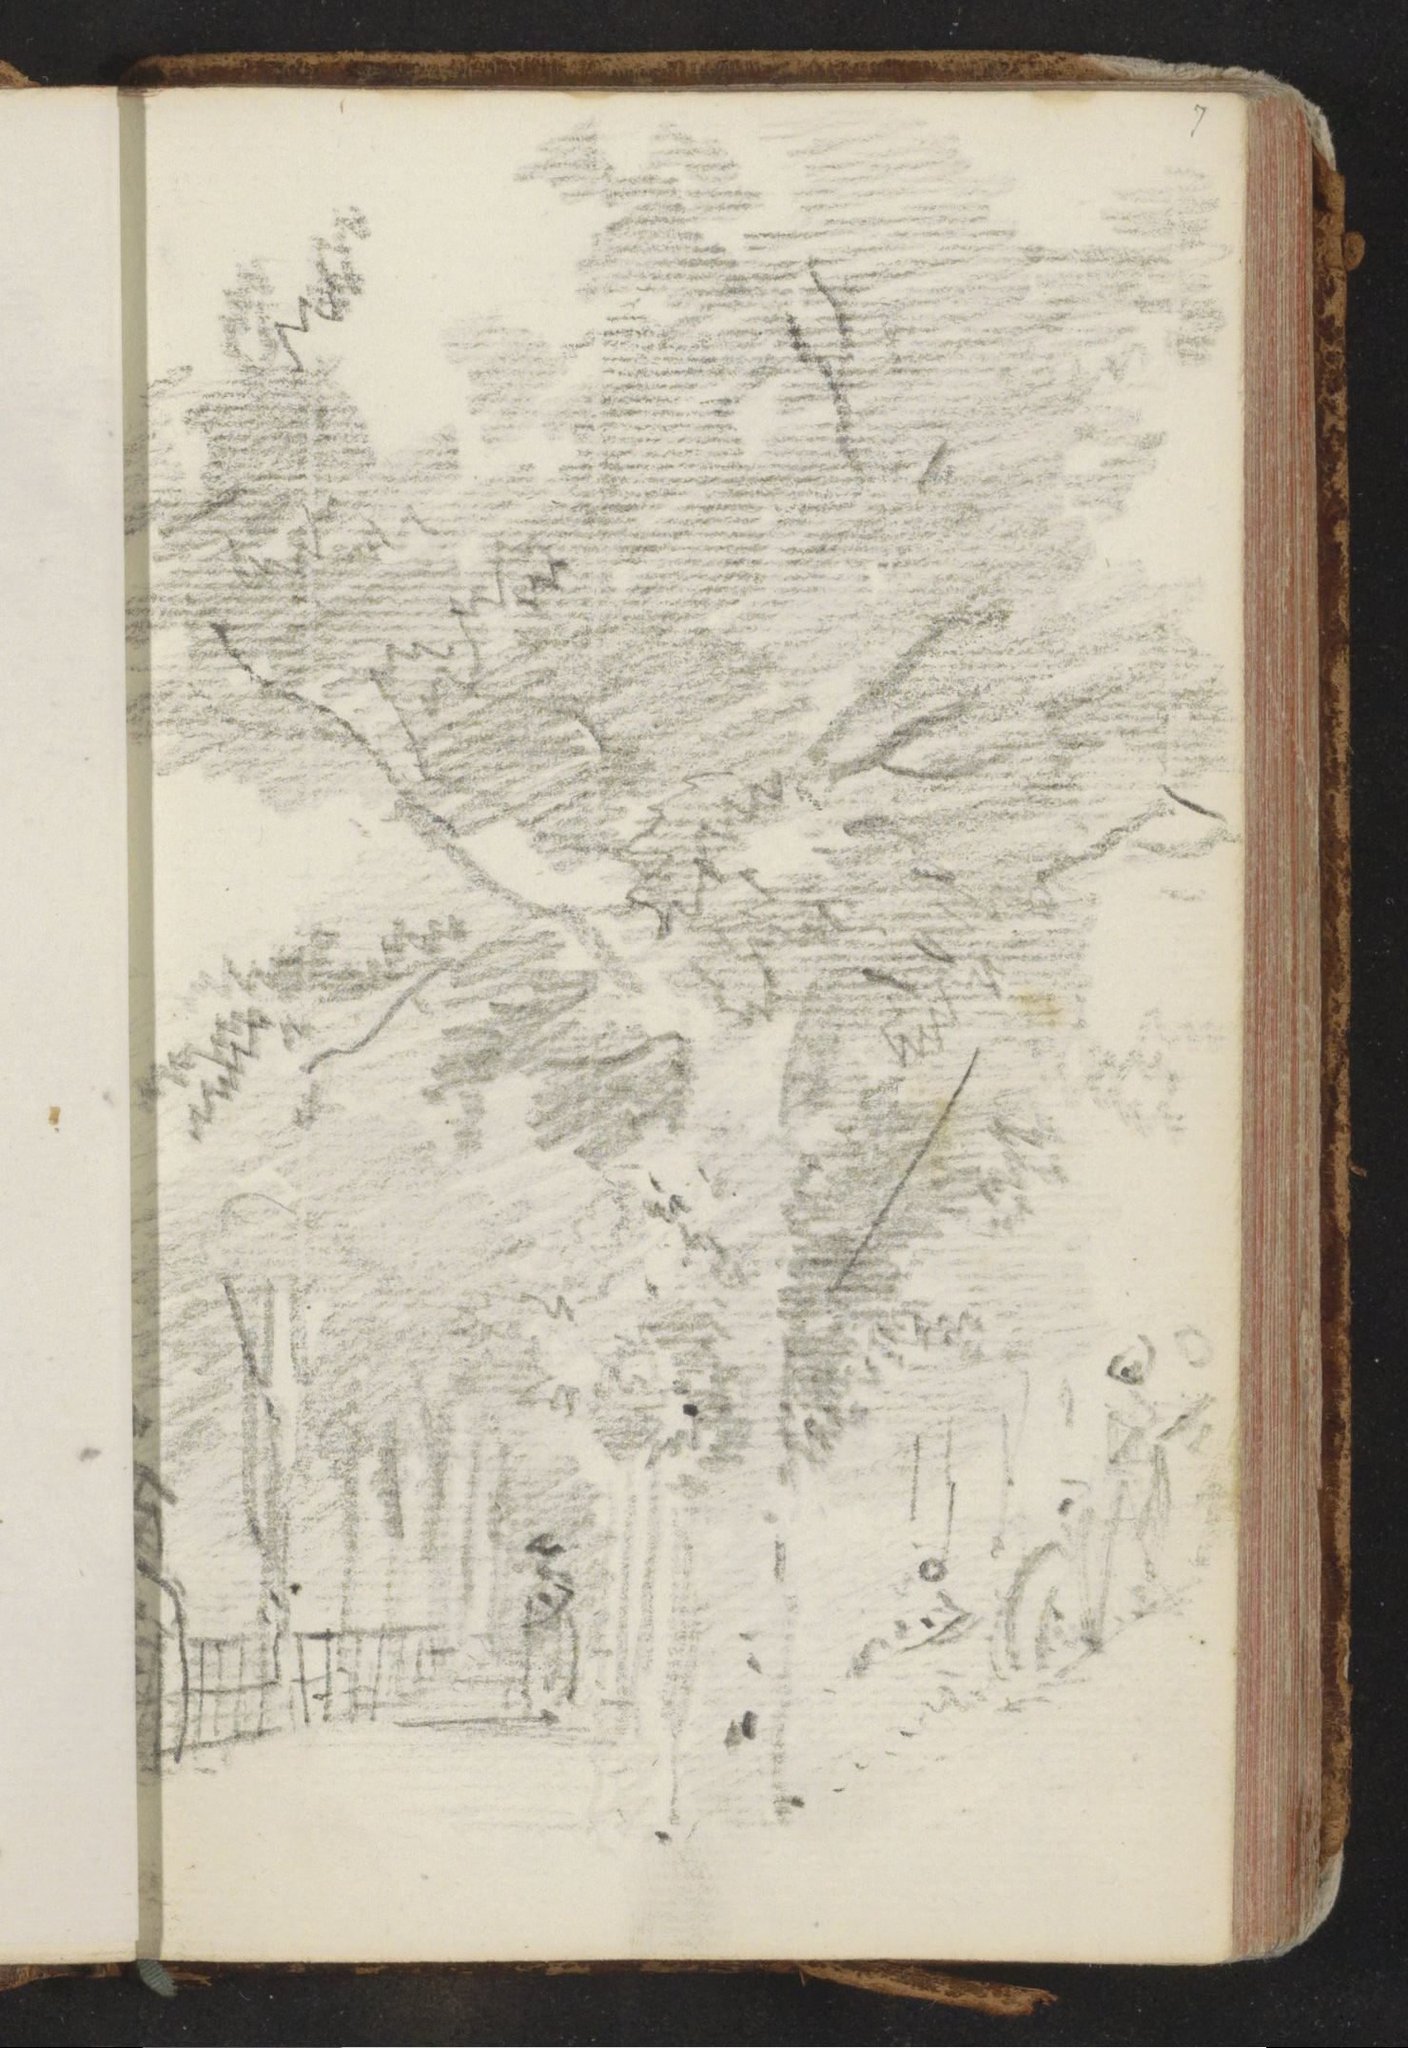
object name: sketchbook leaf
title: Vrouw op een bomenlaan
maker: jean honoré fragonard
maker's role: draughtsman, painter, print maker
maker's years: 1732-1806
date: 1765-1775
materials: paper, pencil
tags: forest path or lane (+ landscape with figures, staffage)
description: Blad 7 recto uit een schetsboek met 83 bladen.